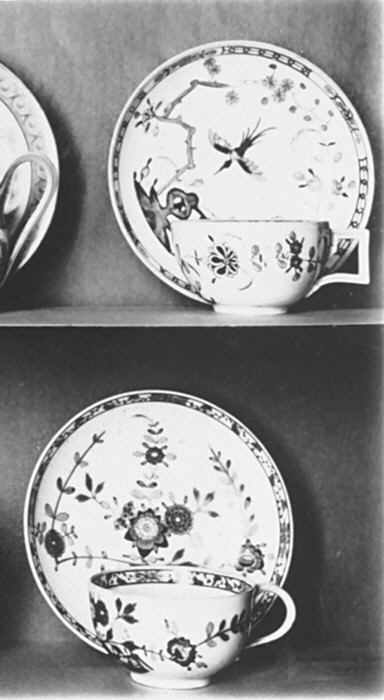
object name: cup and saucer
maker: meissen manufactory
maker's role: manufactory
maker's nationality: german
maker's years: 1710-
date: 1774-1814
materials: hard paste porcelain